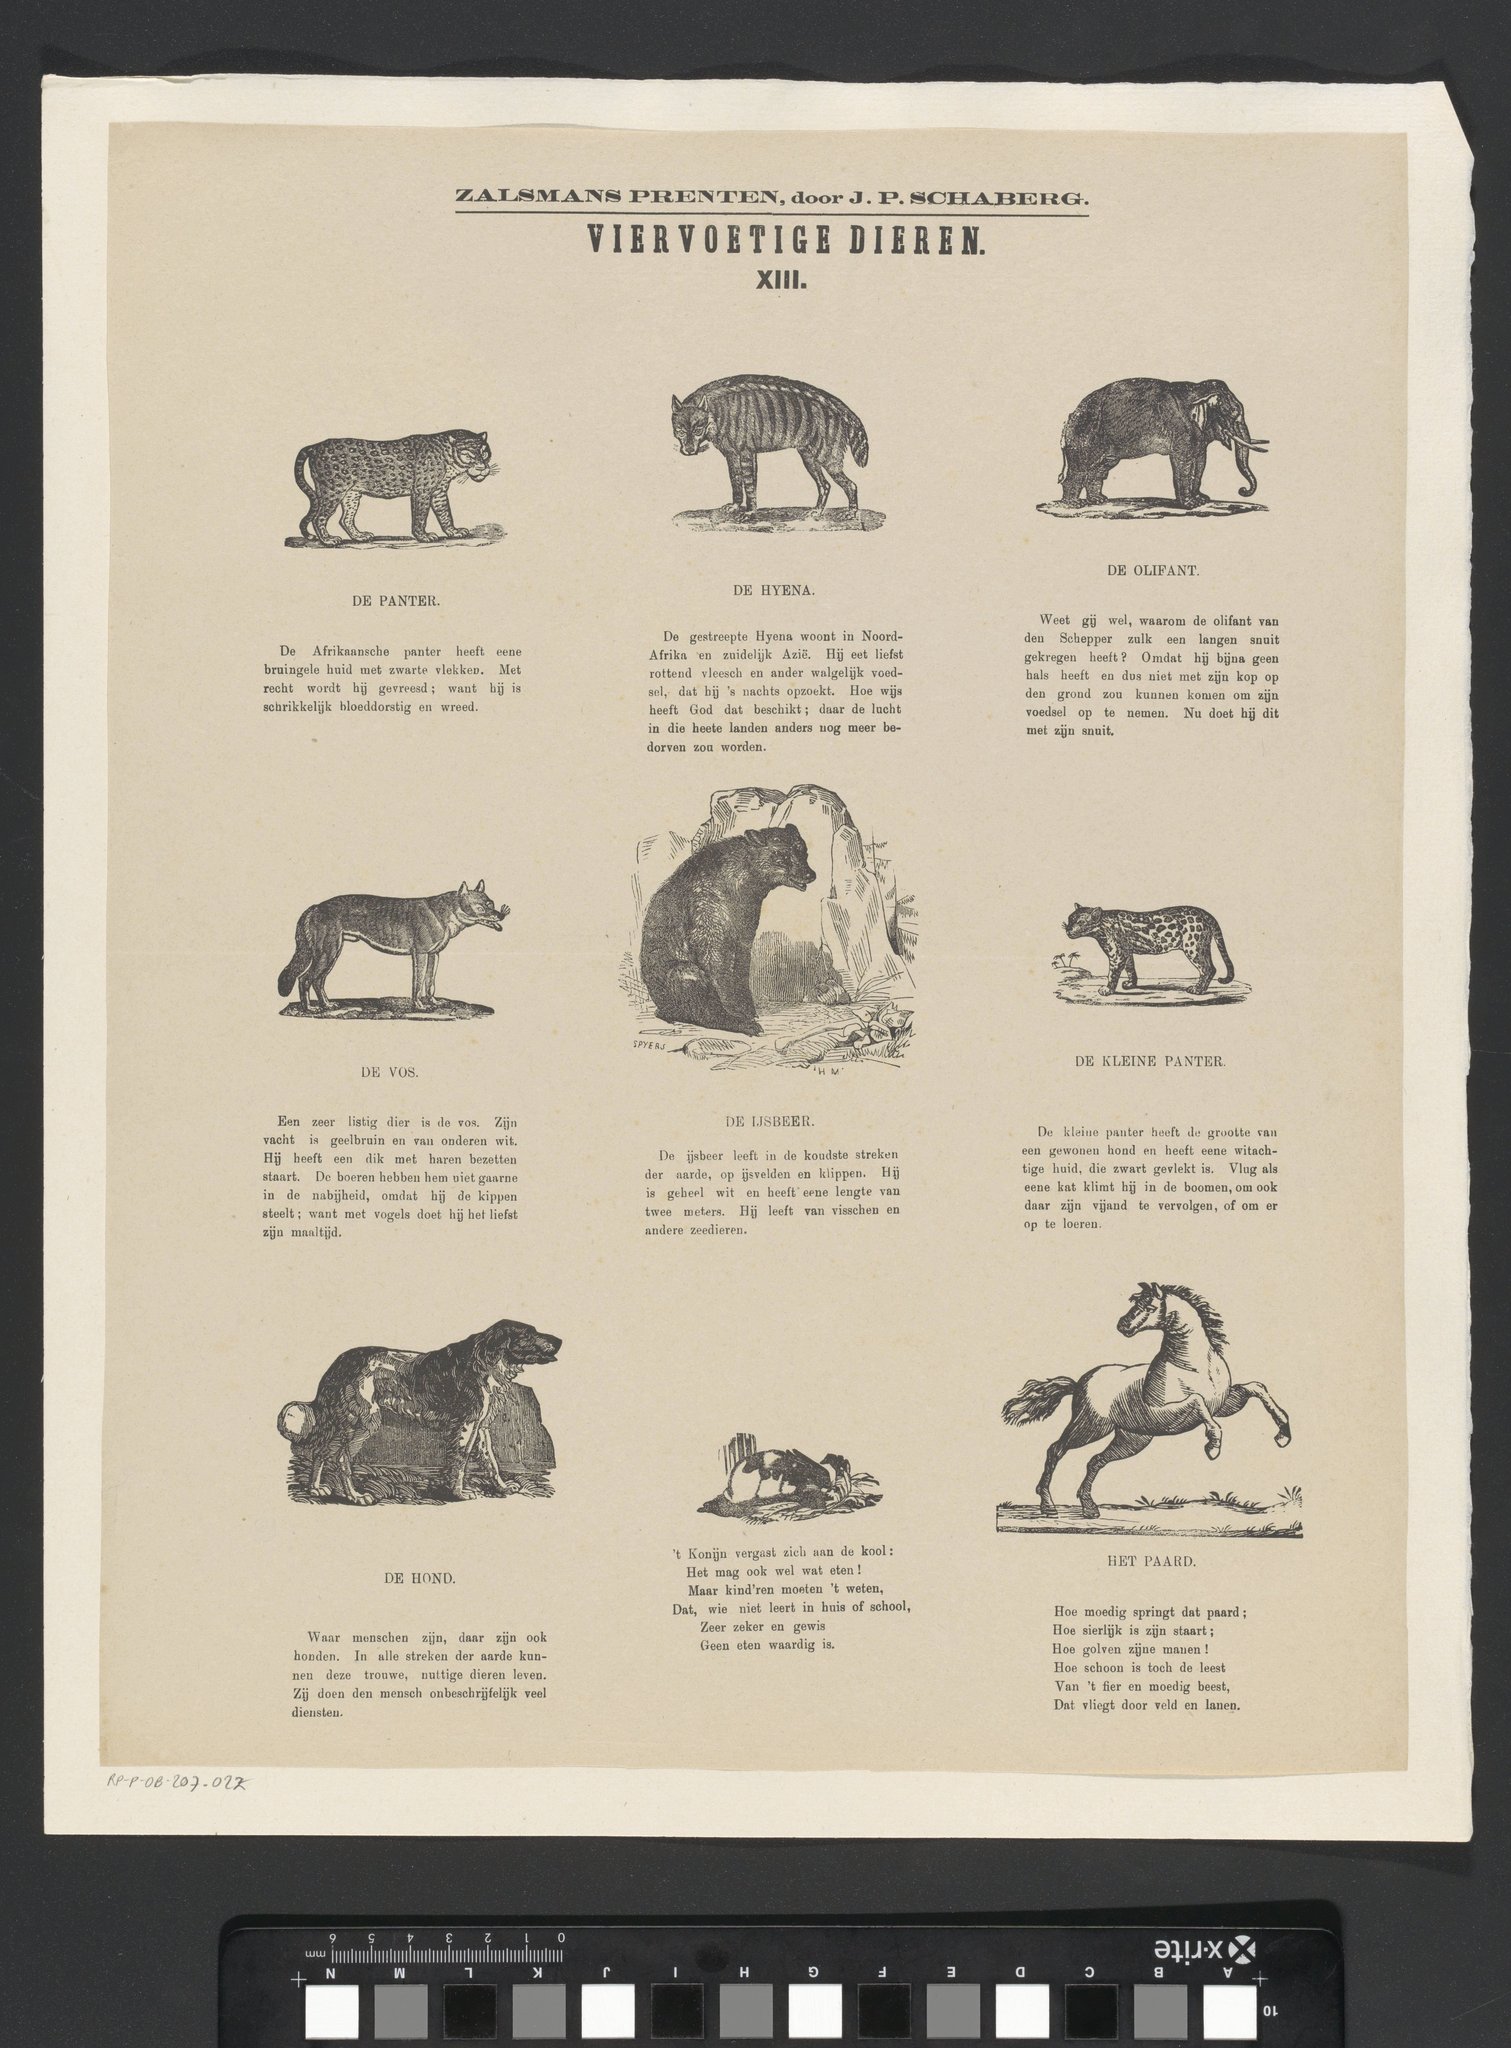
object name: popular print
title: Zalmans prenten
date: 1869-1882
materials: paper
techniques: letterpress printing, engraving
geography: netherlands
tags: animals, beasts of prey, predatory animals: panther, horse, beasts of prey, predatory animals: hyena, trunked animals: elephant, dog, beasts of prey, predatory animals: fox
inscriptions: collector's mark: Lugt 2760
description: Blad met 9 voorstellingen van dieren, zoals een panter, een hyena, een olifant en een vos. Onder elke voorstelling een onderschrift. Genummerd midden boven: XIII.